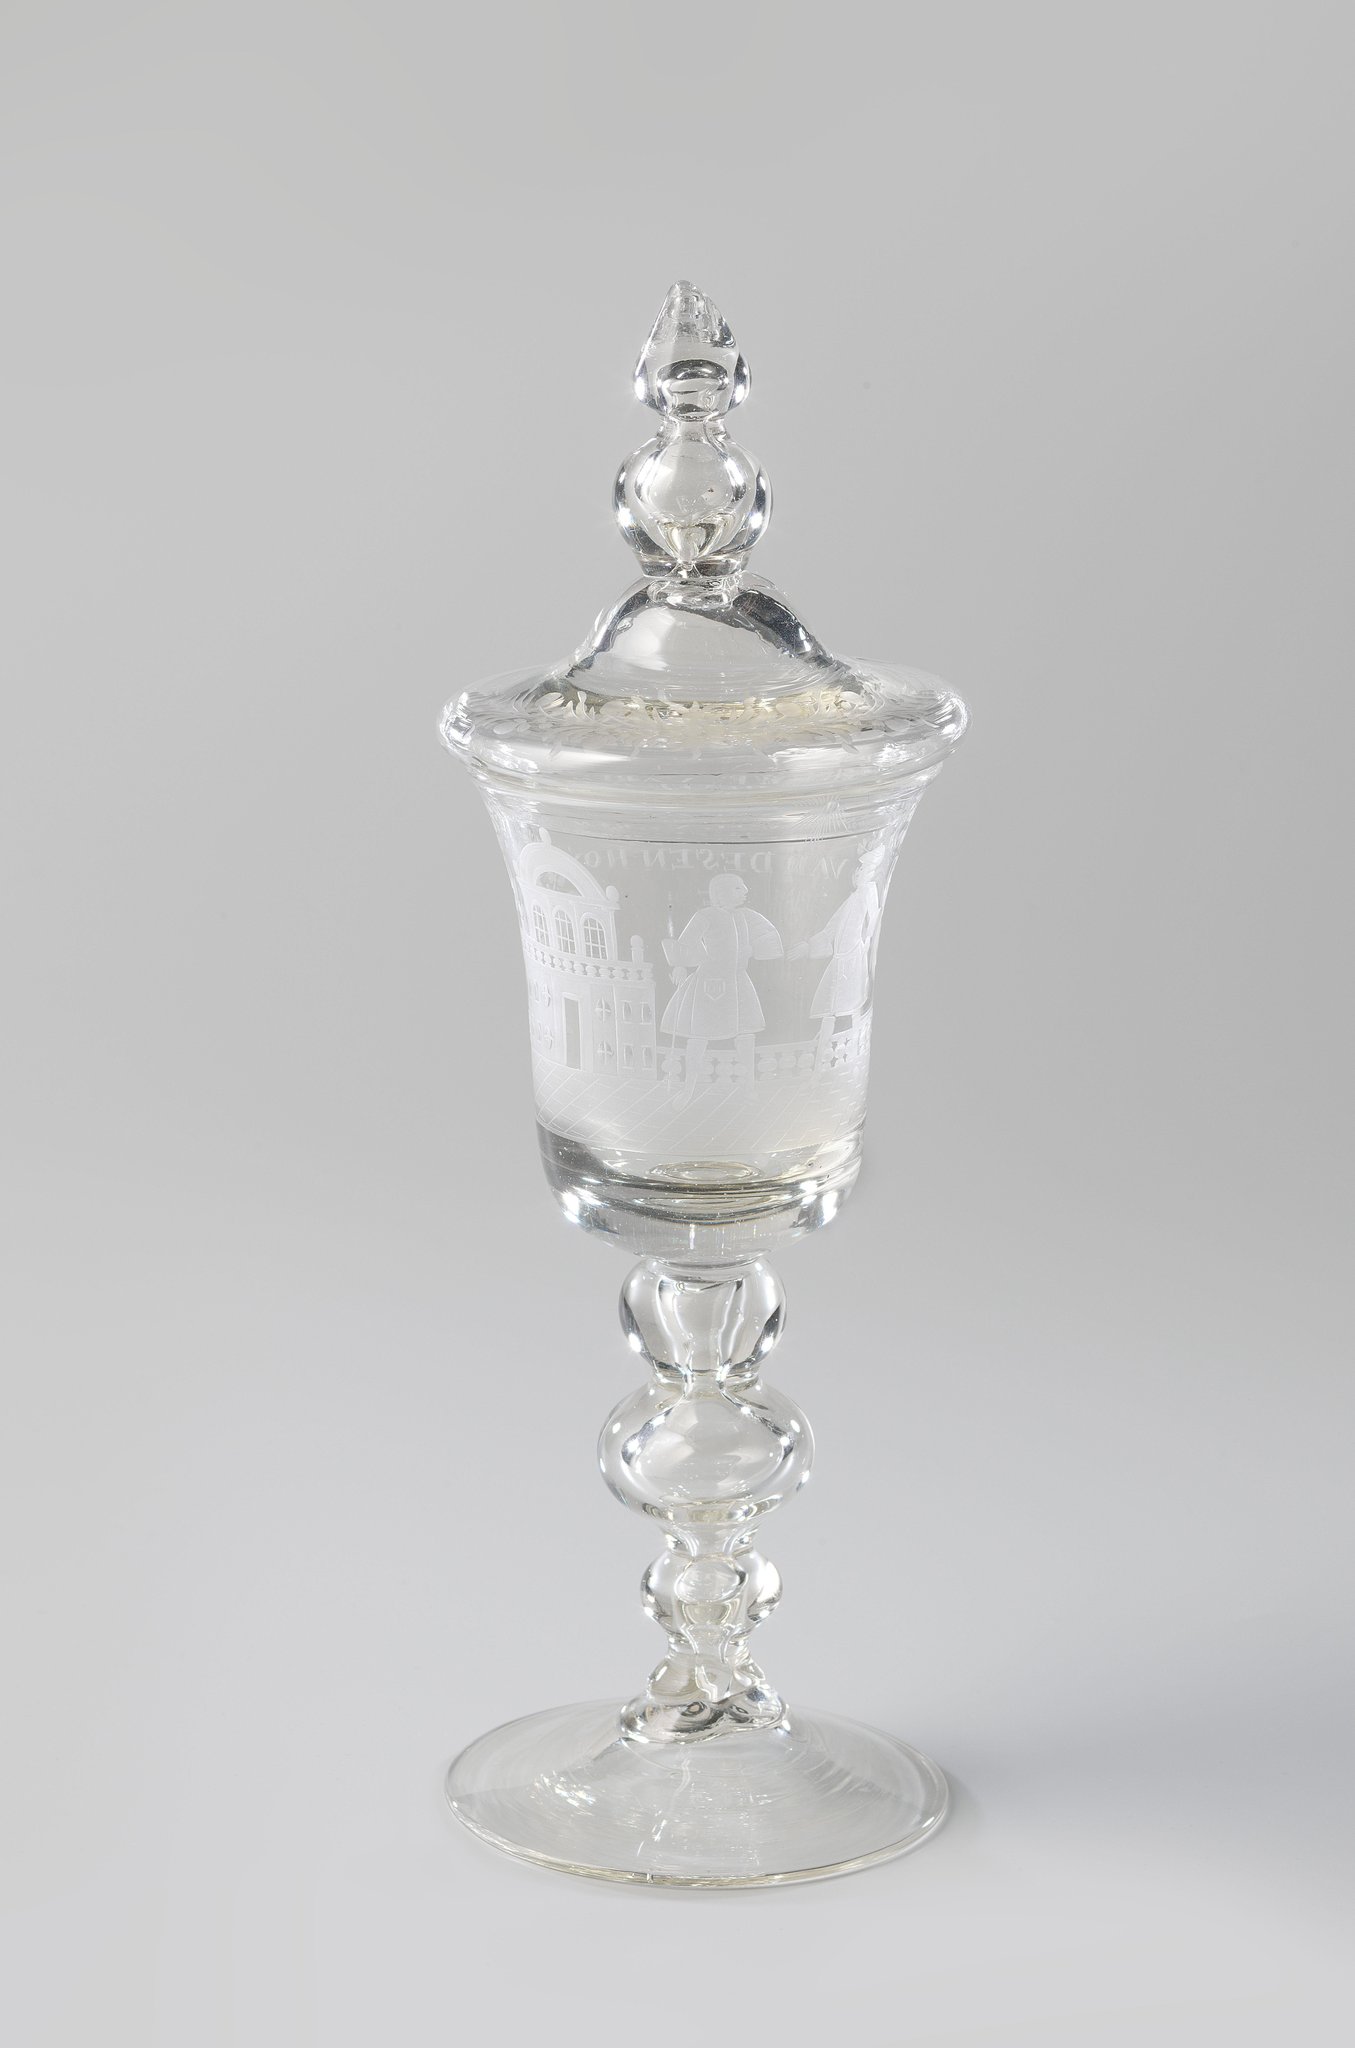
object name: goblet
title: Bokaal met deksel, met een huis en twee heren en het opschrift: HET WELVAREN VAN DESE HOYSE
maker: Anonymous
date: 1725-1750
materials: glass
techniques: glassblowing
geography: northern netherlands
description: Bokaal met deksel. Conische voet met omgeslagen rand. Stam met drie holle knopen, overigens van dik glas. Op de kelk een huis en twee heren in 18de-eeuwse klederdracht tussen bloemkransen. Daarachter: HET WEL VAREN/ VAN DESE HOY/ SE. Op het deksel een bloementuil.